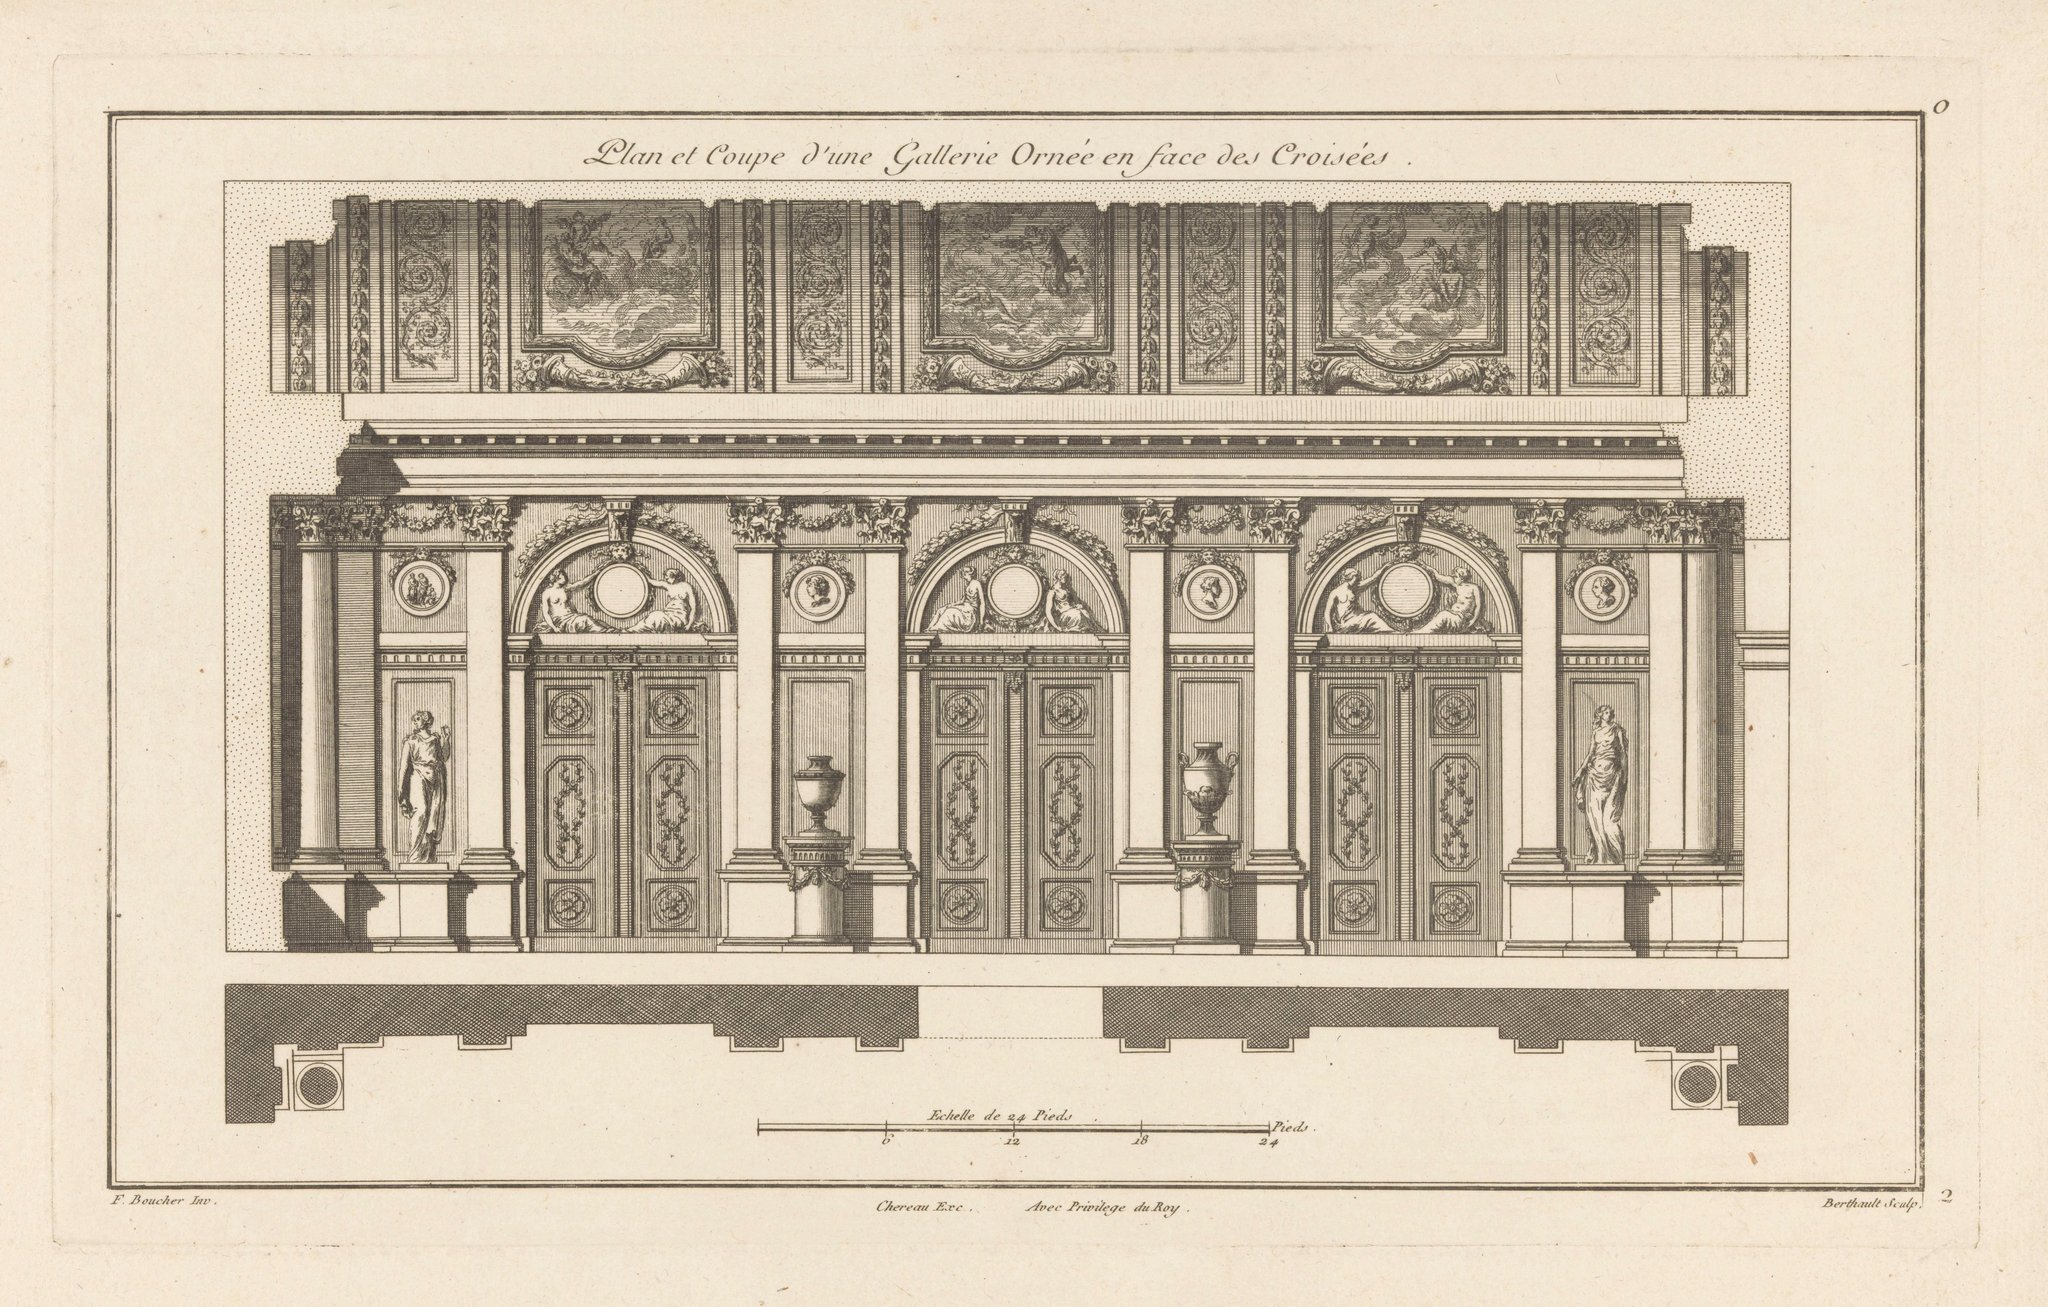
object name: print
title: Plan et Coupe d'une Gallerie Ornée en face des Croisées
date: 1752-1794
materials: paper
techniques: engraving, etching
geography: paris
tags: corridor, vase ~ ornament, door, piece of sculpture, reproduction of a piece of sculpture, half-column, pilaster ~ architecture, picture, painting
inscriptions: collector's mark: Lugt 2760, collector's mark: Lugt 2228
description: Ontwerp en plattegrond van een galerij met drie deuren. De galerij is gedecoreerd met vazen, beelden, pilasters, medaillons, hoornen des overvloeds en schilderingen of wandtapijten.